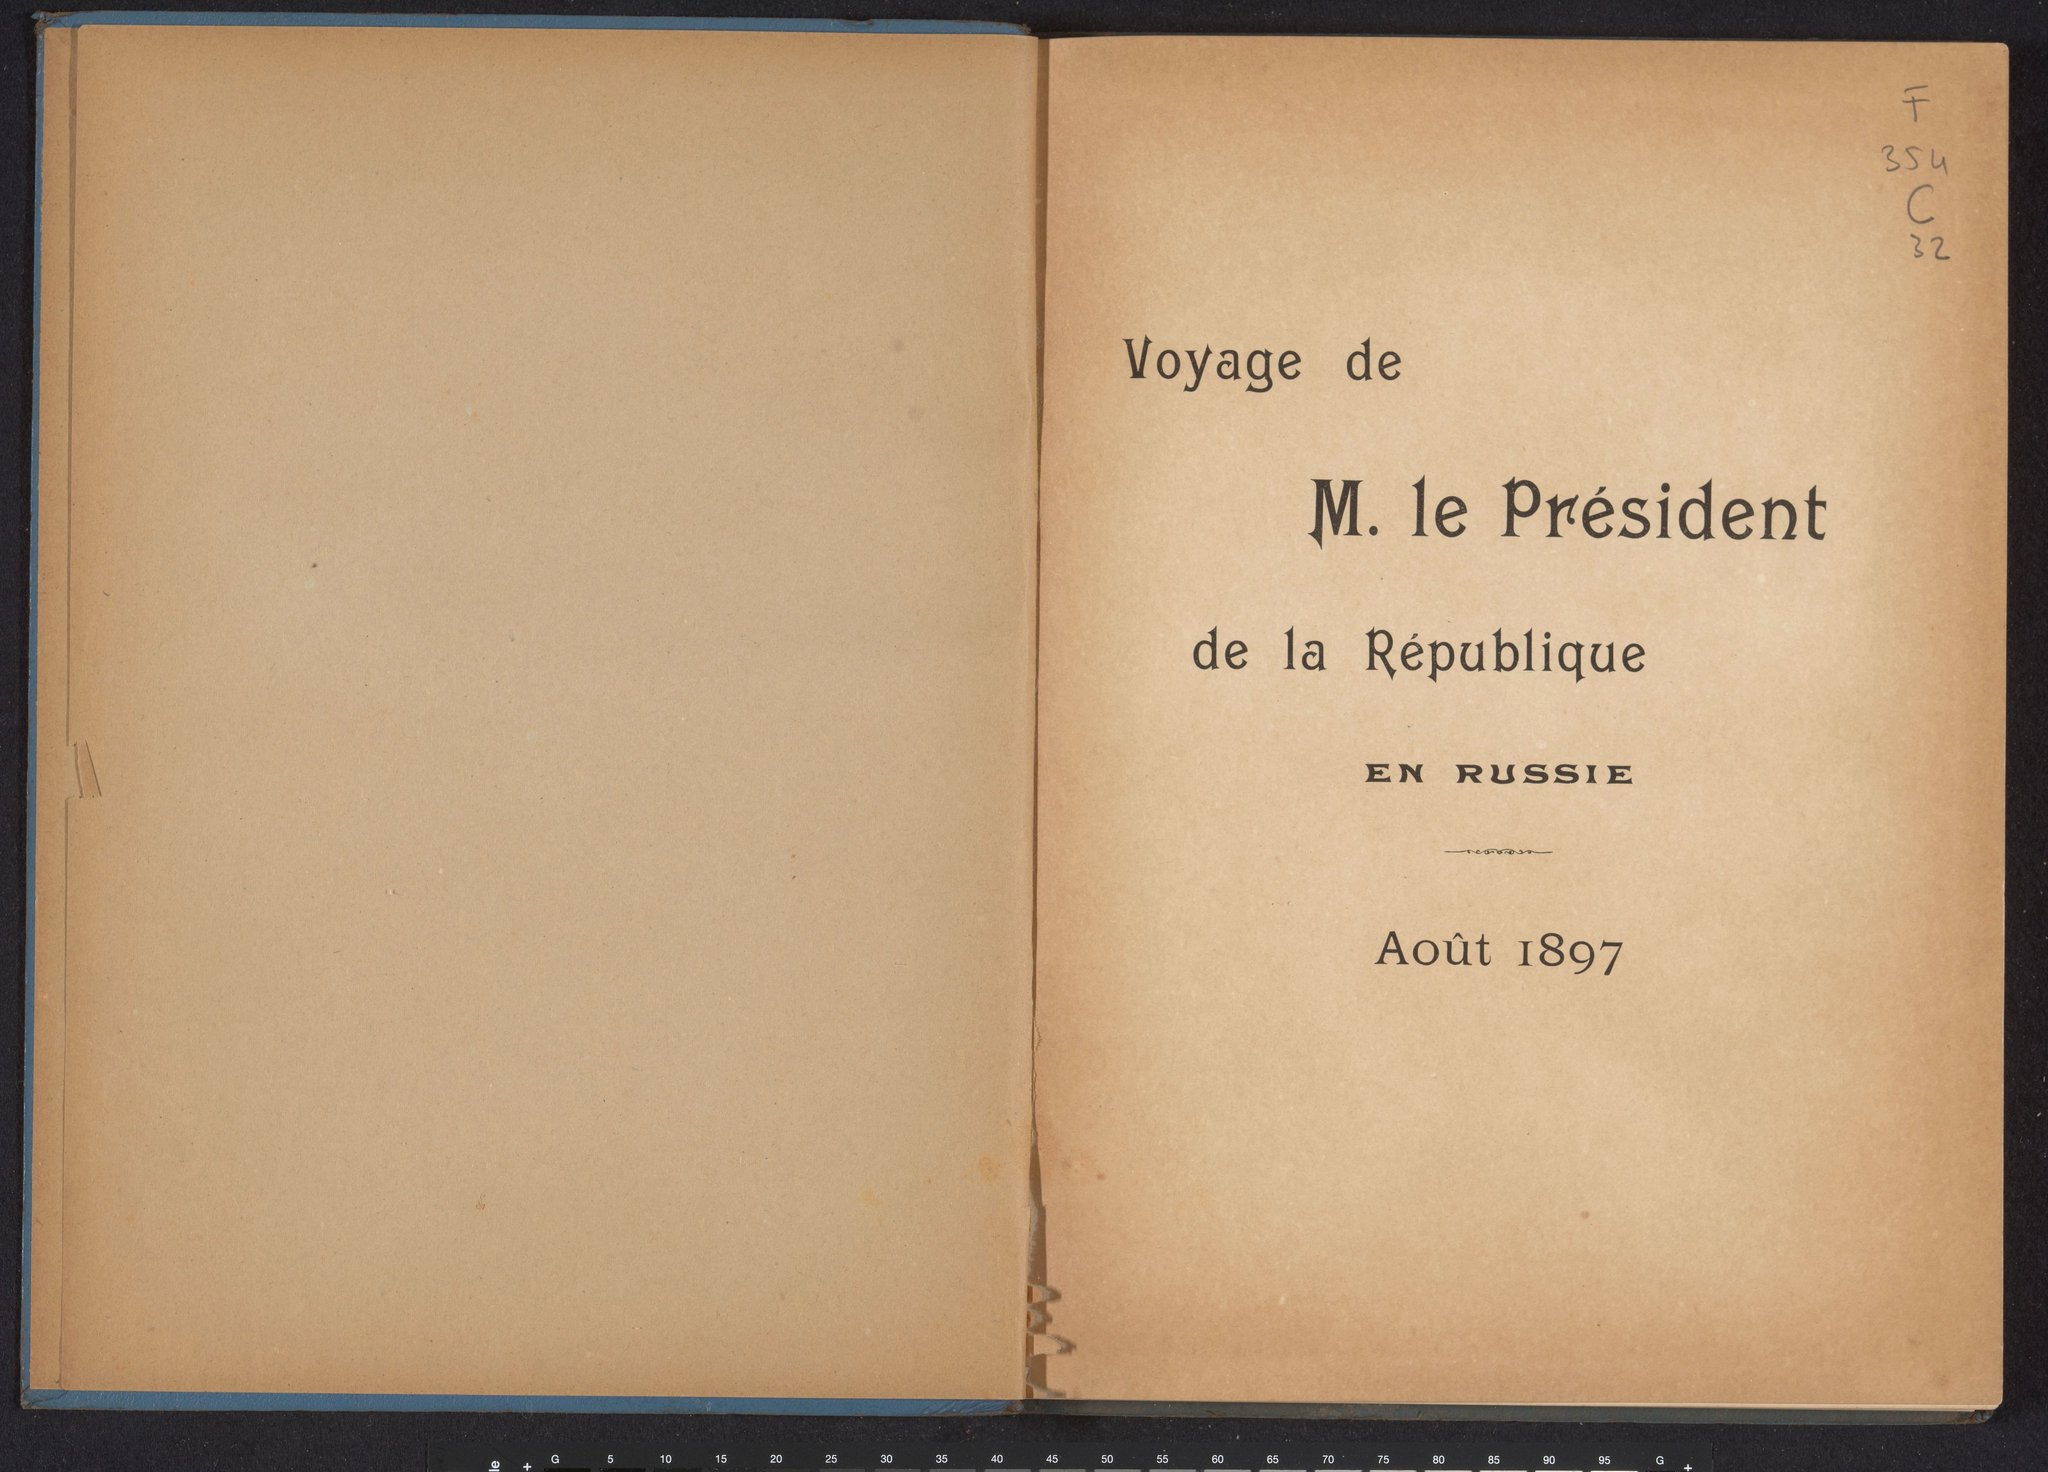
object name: book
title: Voyage de M. le Président de la République en Russie, Août 1897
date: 1897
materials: linen, paper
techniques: photograph, printing